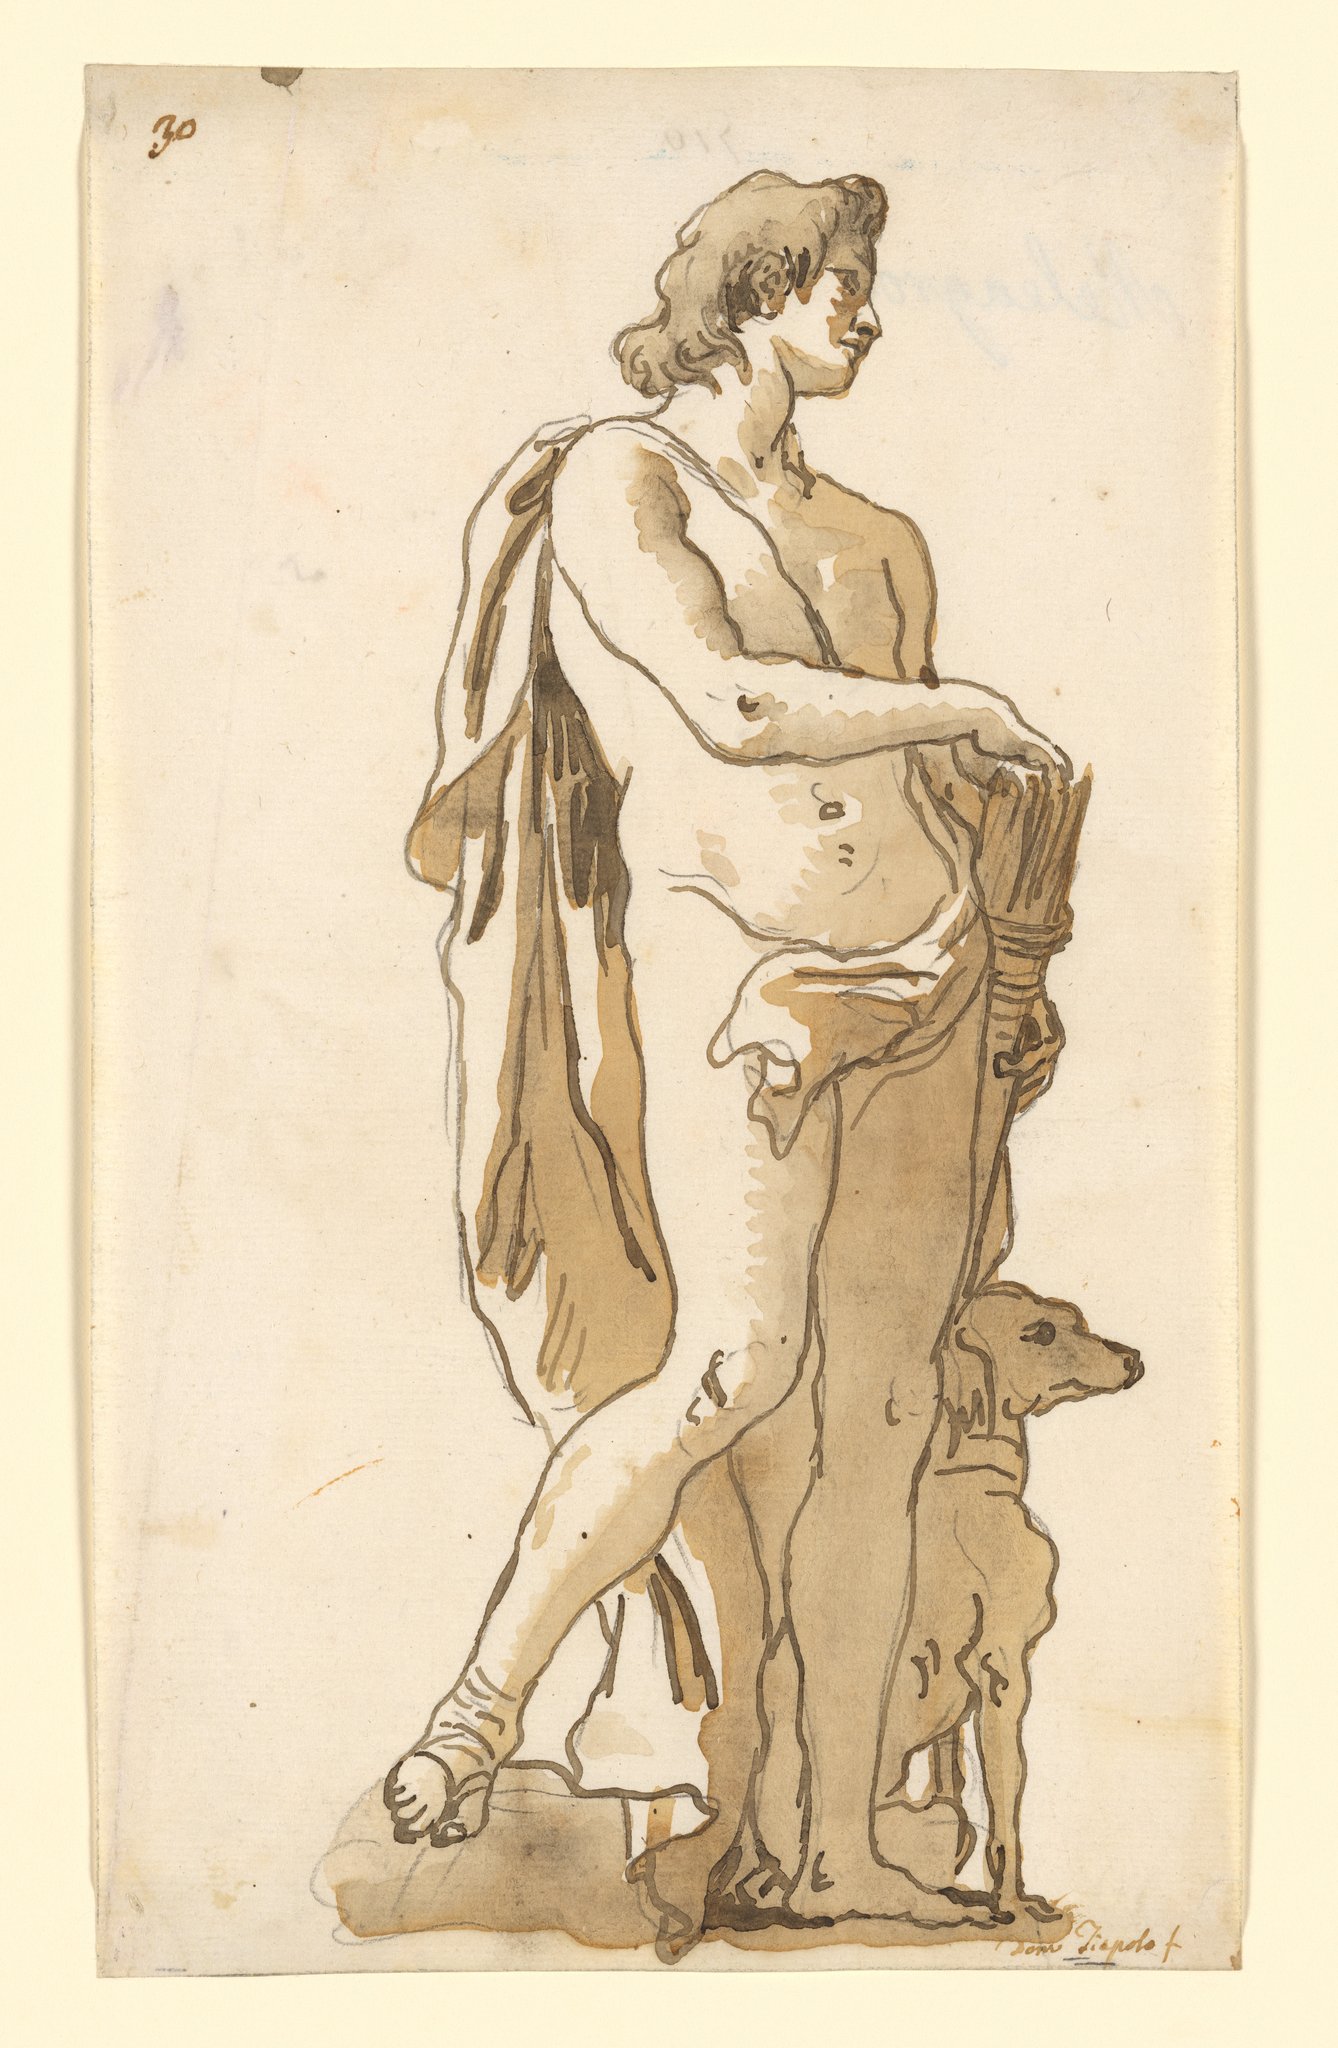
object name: drawing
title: Meleager, Turning to the Right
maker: giovanni domenico tiepolo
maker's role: artist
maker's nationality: italian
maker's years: 1727-1804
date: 1734-1833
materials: chalk, ink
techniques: pen, wash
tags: men,dogs